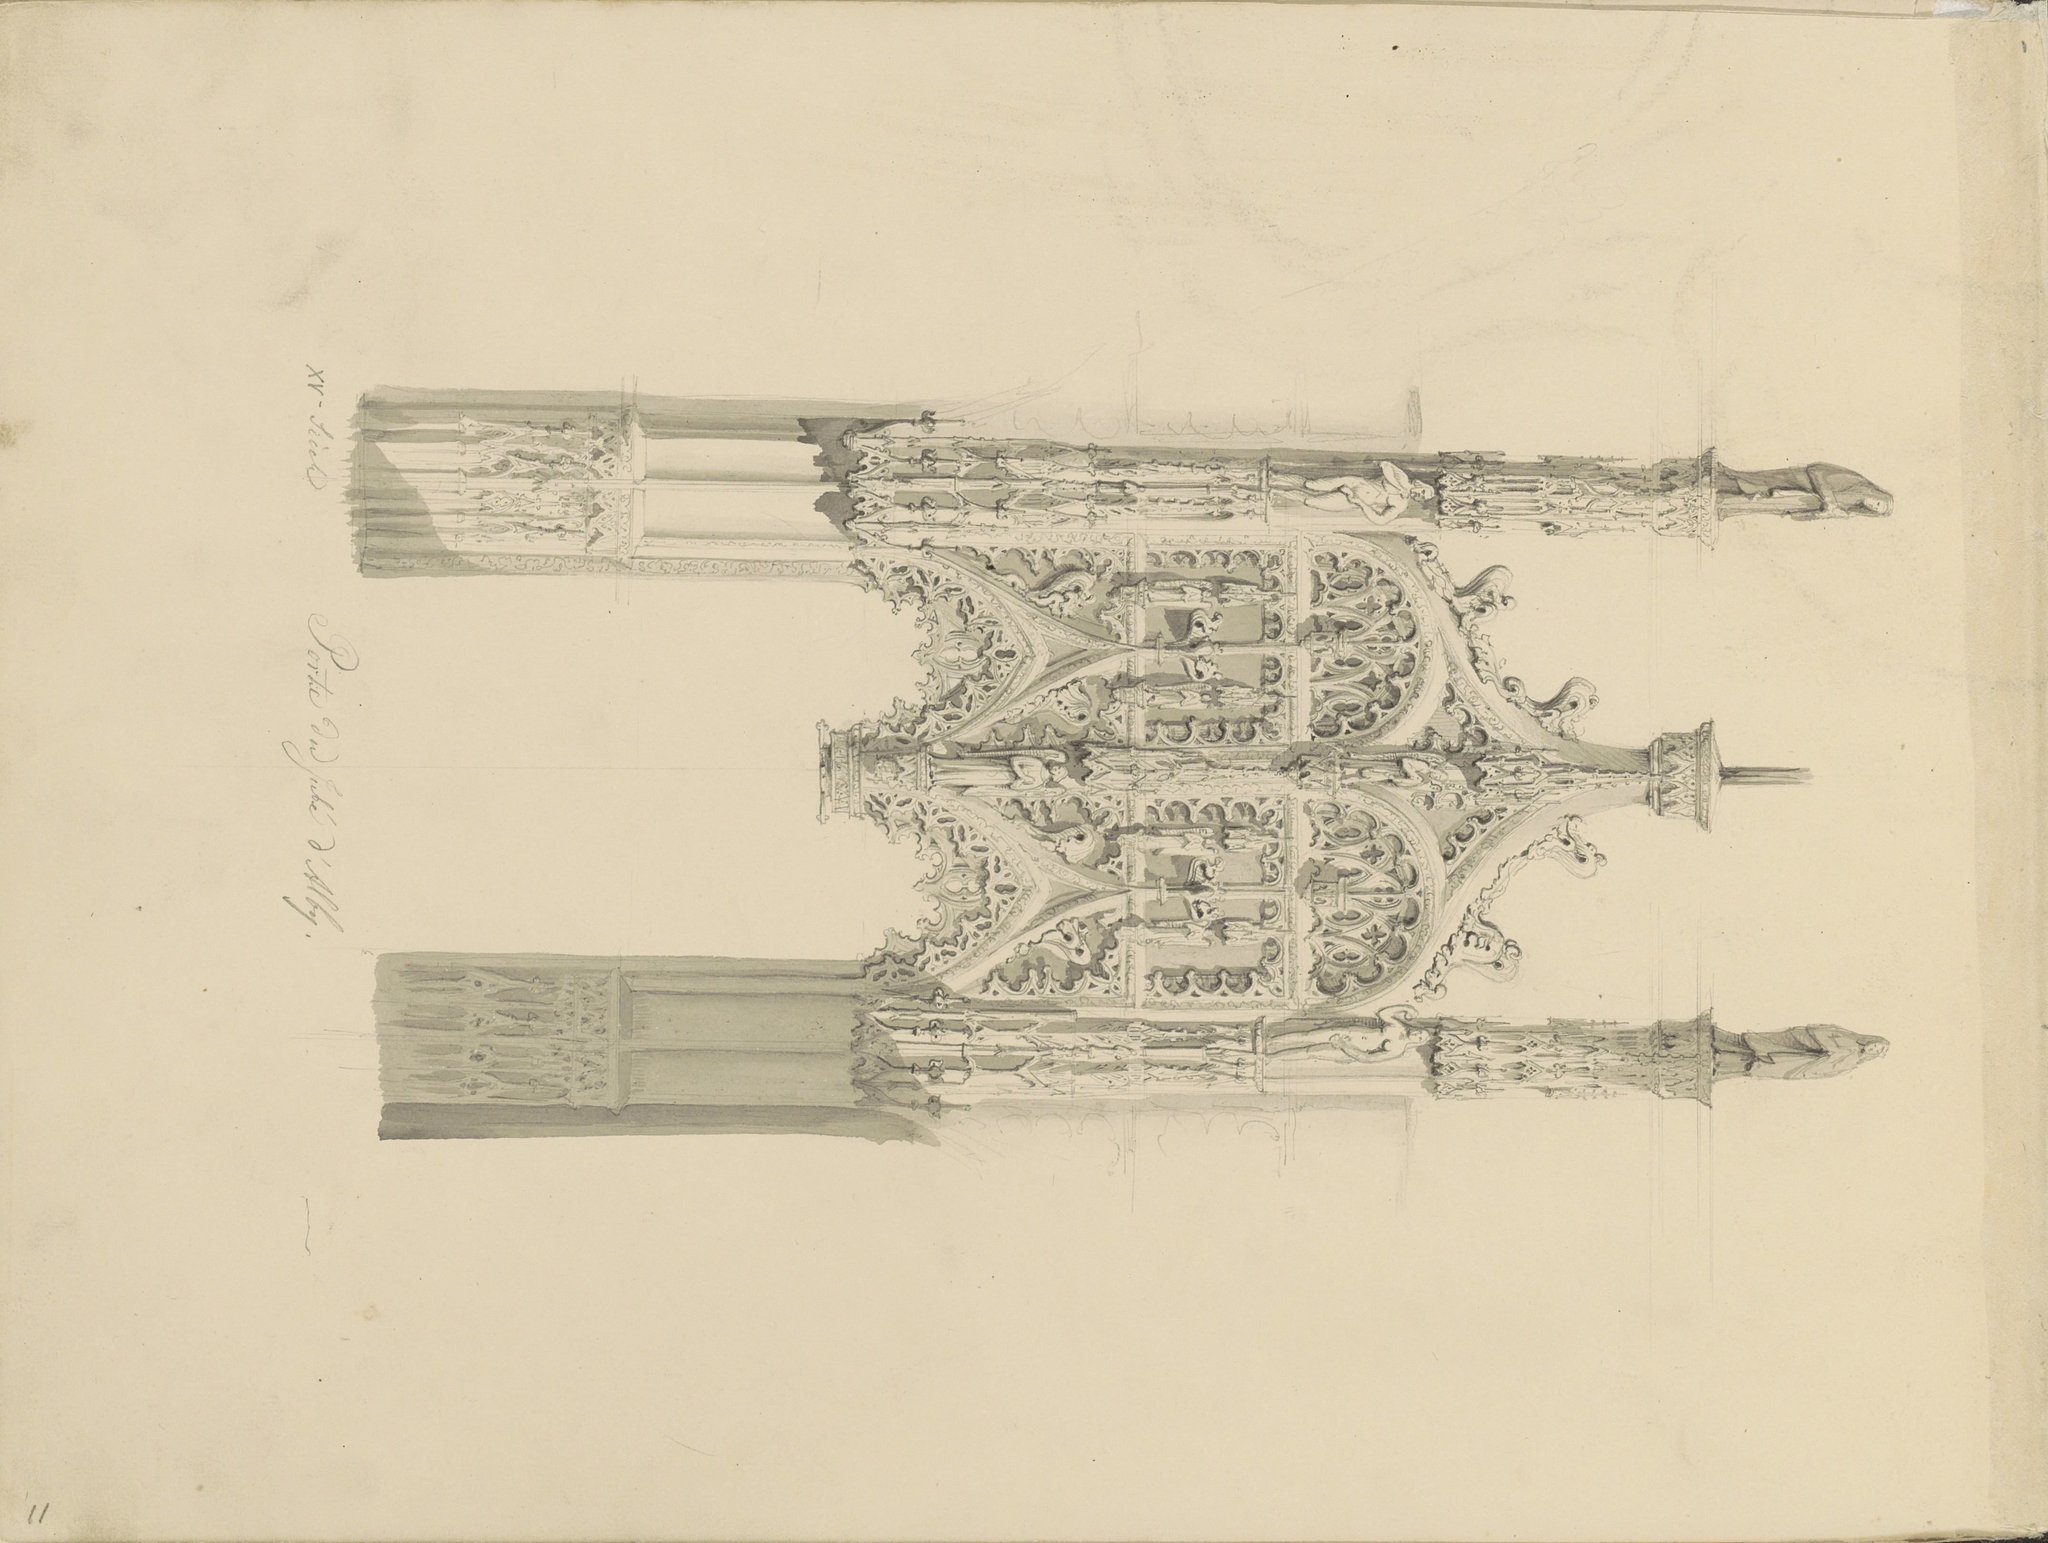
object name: sketchbook leaf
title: Deel van een afscheidingswand voor het altaar in de Kathedraal Sainte-Cécile te Albi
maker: pierre joseph hubert cuypers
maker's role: draughtsman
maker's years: 1827-1921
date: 1850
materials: paper, pencil, watercolor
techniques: brush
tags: rood-screen, choir-screen; iconostasis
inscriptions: annotation: ‘XV-siècle Partie du Jubé d'Alby’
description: Blad 22 verso uit een schetsboek met 37 bladen.